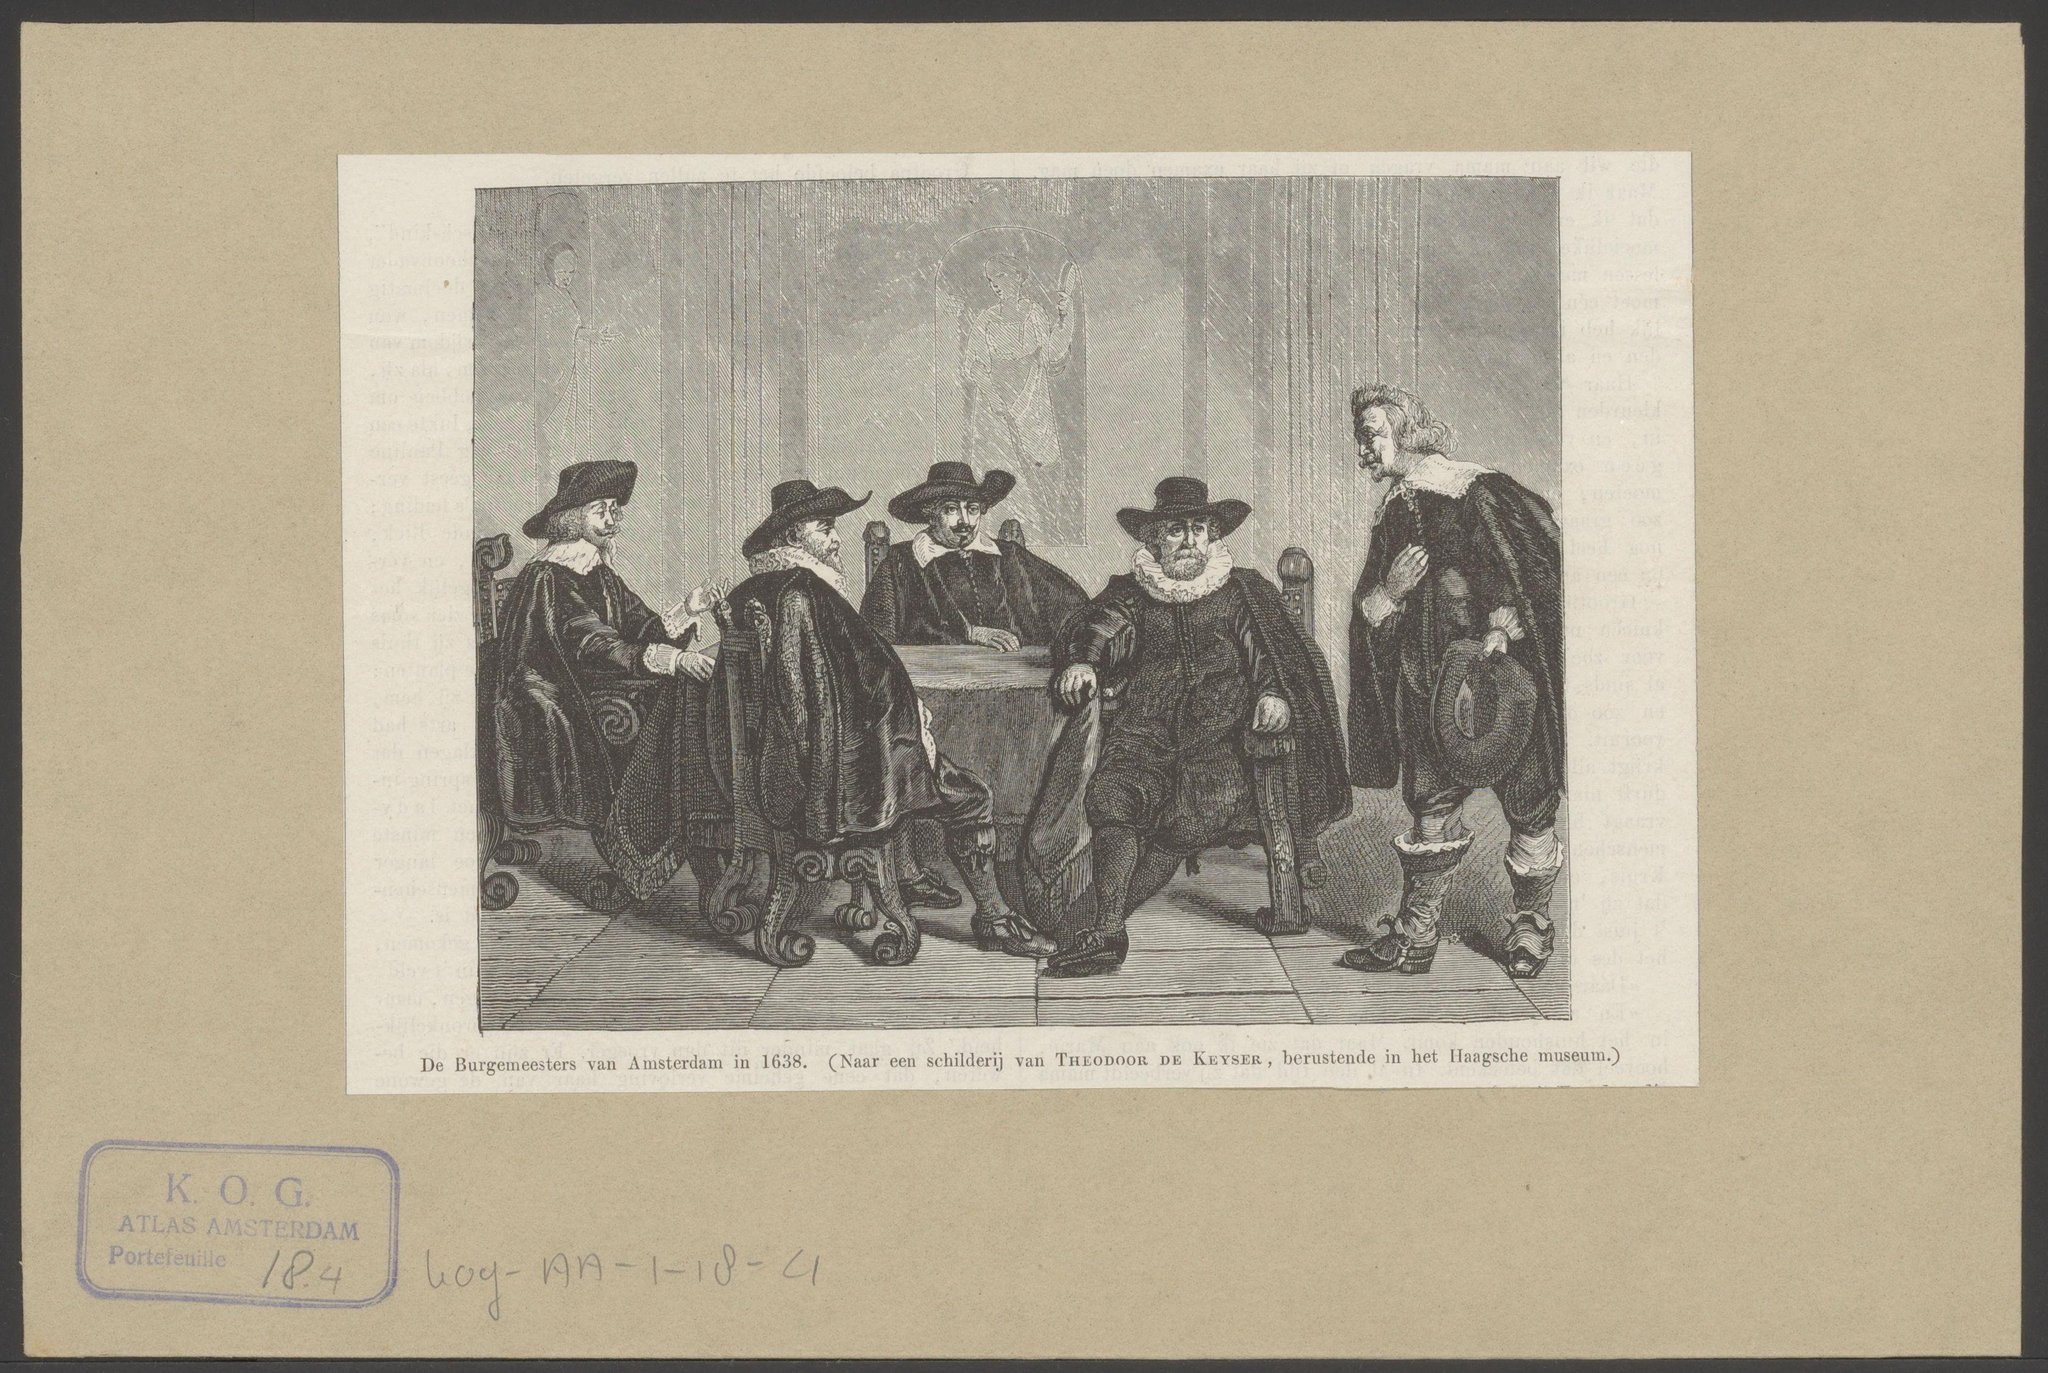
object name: print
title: Groepsportret van de vier Amsterdamse burgemeesters wachtend op het bericht van de aankomst van Maria de´ Medici in 1638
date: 1878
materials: paper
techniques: letterpress printing, engraving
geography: haarlem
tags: abraham boom, mayor, cologne, print maker, maria de' medici, mayor, burgomaster, amsterdam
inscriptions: collector's mark: ‘18.4’ Lugt 1641b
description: Onderwerpsrubriek binnen de Atlas Amsterdam: Herinneringen aan regeringsleden en hunne huisgezinnen [voor 1800]. Gezeten rond een tafel zijn: Antonius Oetgens van Waveren, Albert Coenraads Burgh, Pieter Hasselaer en Abraham Boom. Links staande de advocaat Cornelis Davelaer.